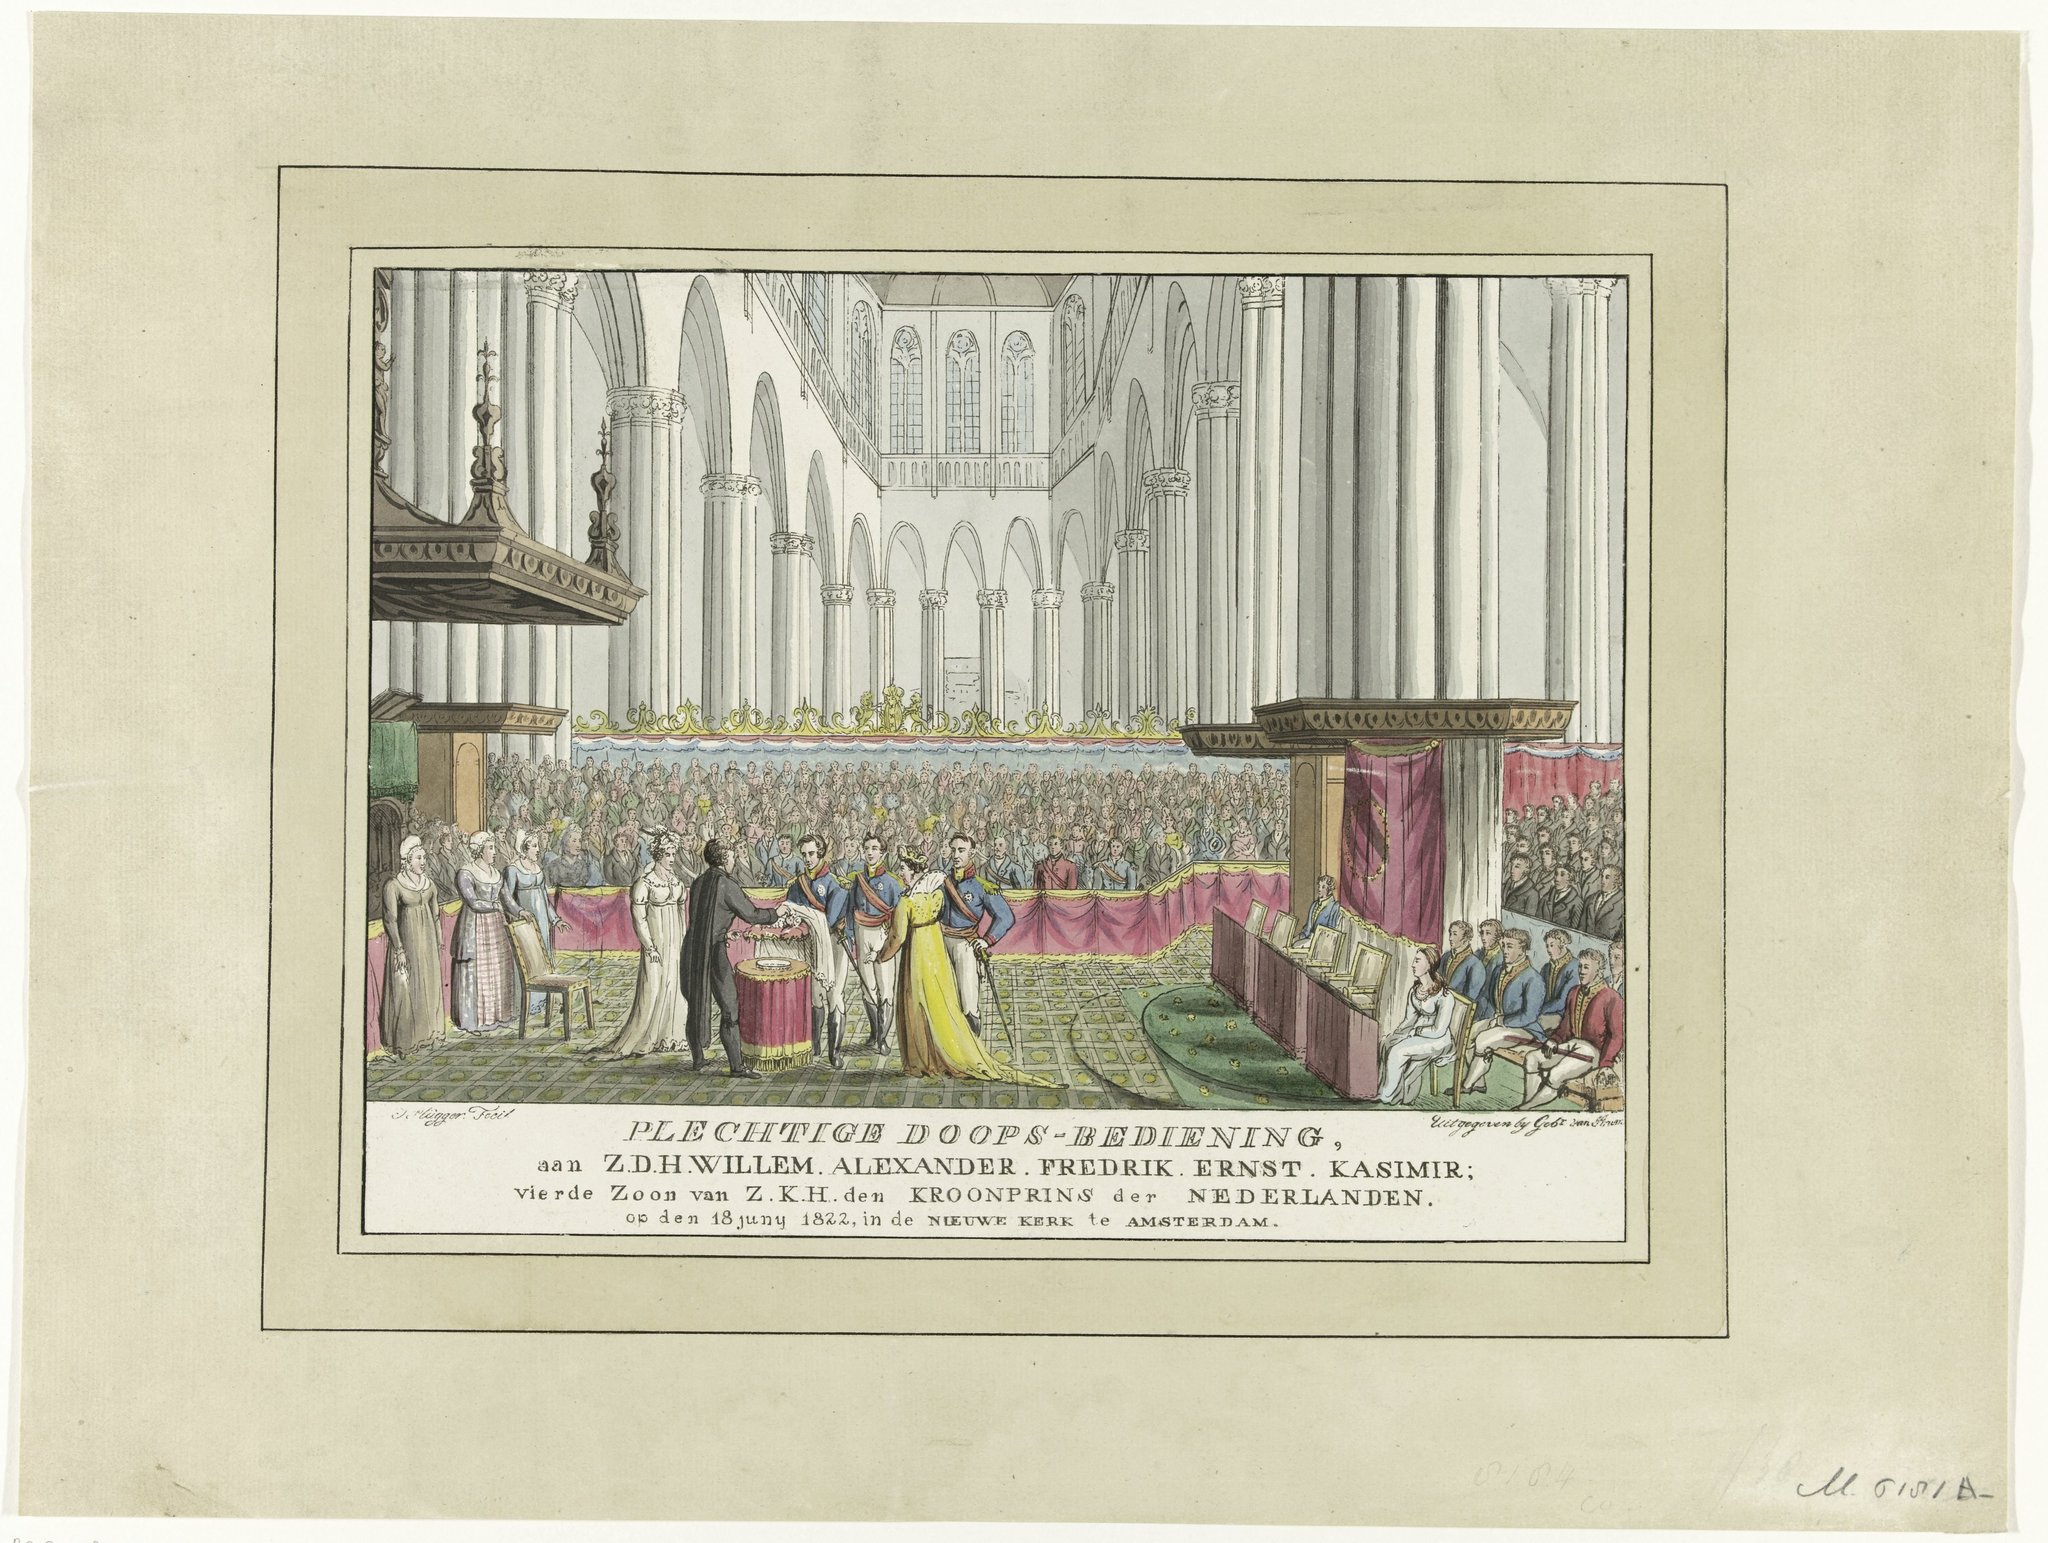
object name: print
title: Plechtige Doops-bediening, aan Z.D.H. Willem. Alexander. Fredrik. Ernst. Kasimir; vierde Zoon van Z.K.H. den Kroonprins der Nederlanden. op den 18 juny 1822, in de Nieuwe Kerk te Amsterdam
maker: jacob plügger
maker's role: print maker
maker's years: 1795-1871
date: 1822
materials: paper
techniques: hand coloring, lithograph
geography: amsterdam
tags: hoorn (north holland), the hague, brussels, baptism ~ protestant service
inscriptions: collector's mark: Lugt 2228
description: Doop van Ernst Casimir, prins van Oranje-Nassau, 18 juni 1822 in de Nieuwe Kerk te Amsterdam. Ernst Casimir was de vierde zoon van de latere Nederlandse koning Willem II en Anna Paulowna. Doopceremonie in een volle kerk voltrokken door ds. Dermout. Centraal staan de leden van het het Koninklijk Huis, rechts hun zitplaatsen. Op de achtergrond zitten de genodigden.